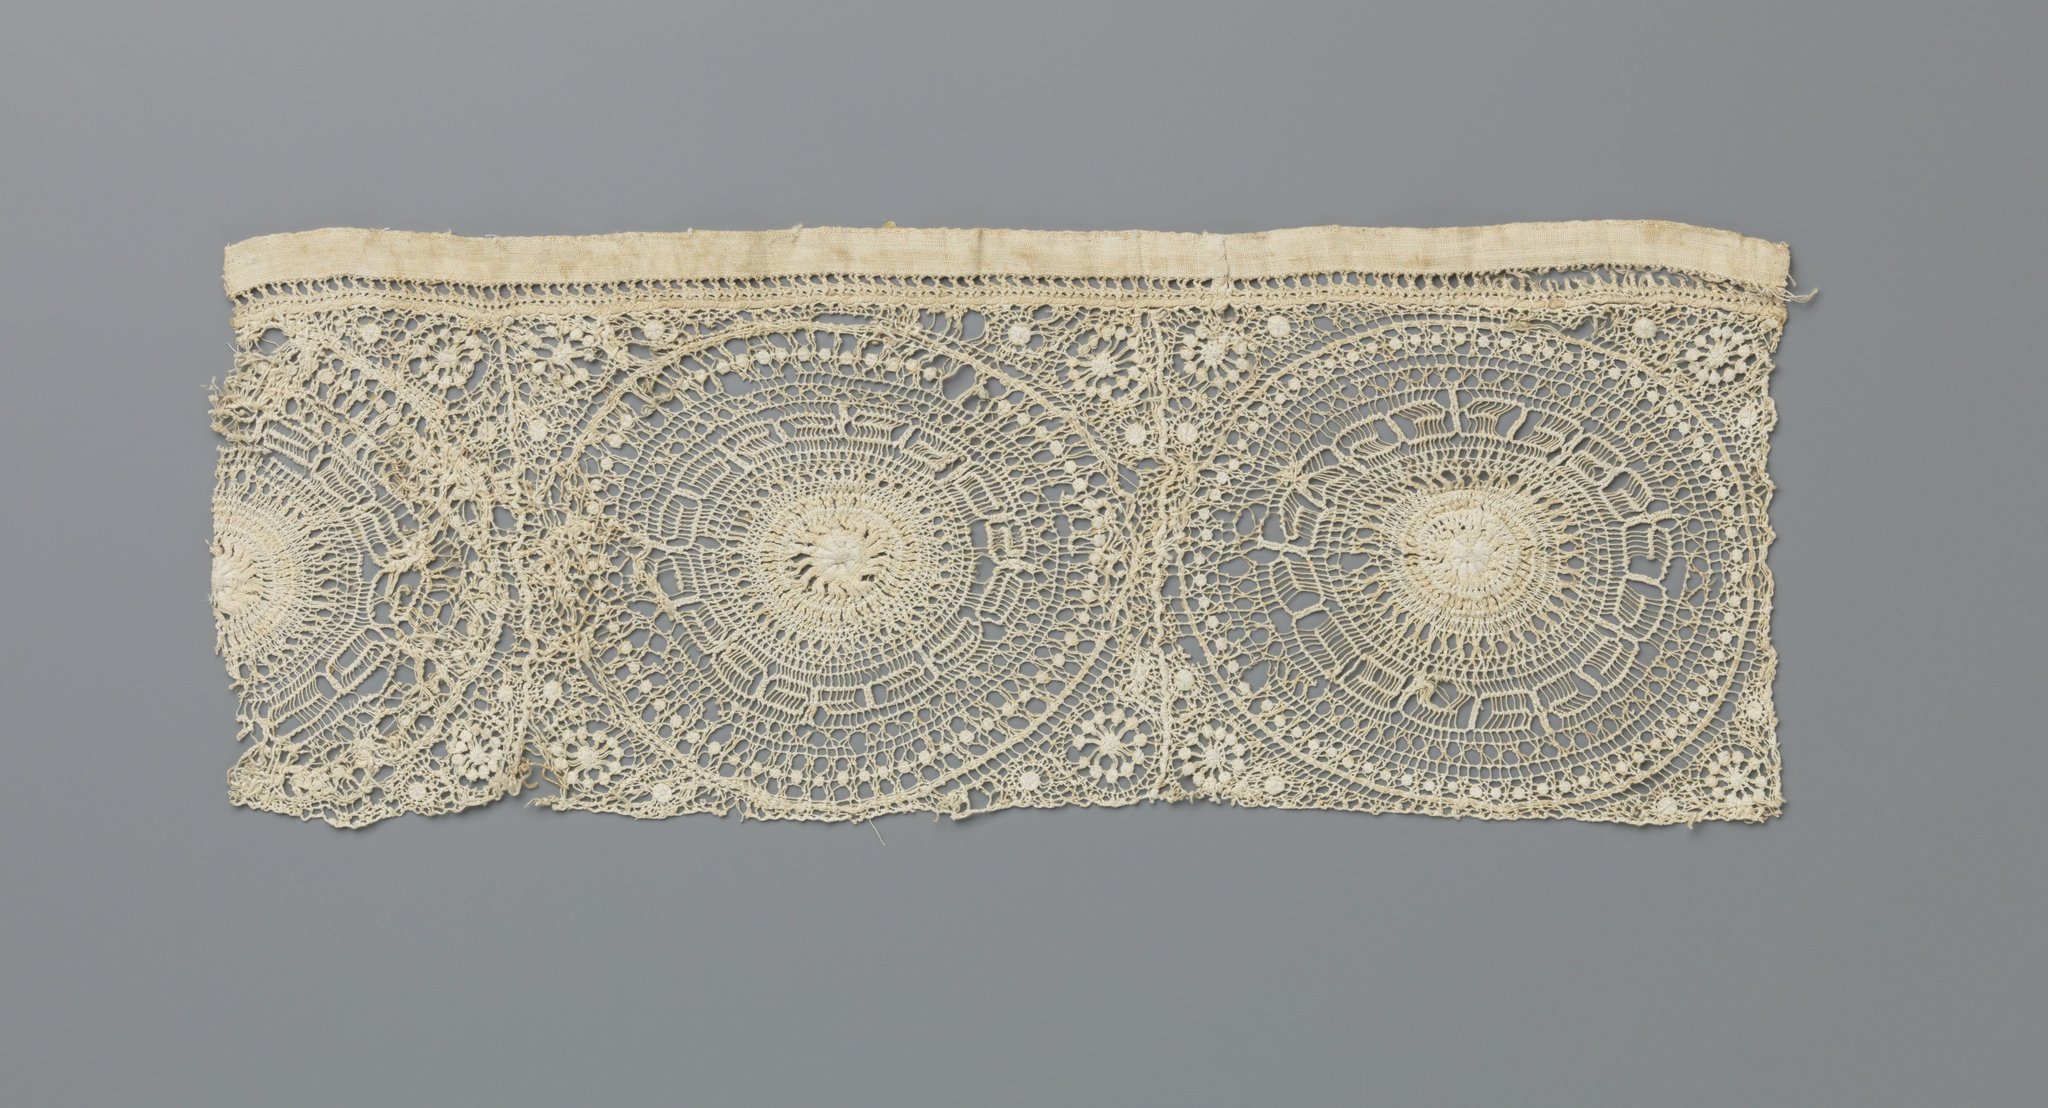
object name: strip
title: Strook naaldkant met zonnen waarom een sierlijst met hoekig omkrullende lijnen die rechthoekjes vormen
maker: Anonymous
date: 1700-1799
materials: linen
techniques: lace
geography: spain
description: Strook naturelkleurige zonnekant (naaldkant): Tenerife-kant. Het zich herhalende patroon bestaat uit een vierkant veld met daarin een 'zon': een cirkelvormig centrum waaruit gebundelde draden de zonnestralen vormen. Om het centrum heen staan smalle concentrische sierlijsten, die naar buiten toe steeds breder worden. Halverwege valt een lijst met hoekig omkrullende lijnen op, die een aaneenschakeling van rechthoekige motiefjes vormen. In de buitenste sierlijst een aaneenschakeling van stipjes. In het vierkante veld staan in elke hoek, buiten de cirkel, drie cirkeltjes waarvan de middelste cirkel een zon vormt, met een stipje aan het uiteinde van elke zonnestraal. De bovenzijde van de strook is afgewerkt met een smalle linnen band, met een opengewerkte rand. De strook toont twee-en-een-halve zon.